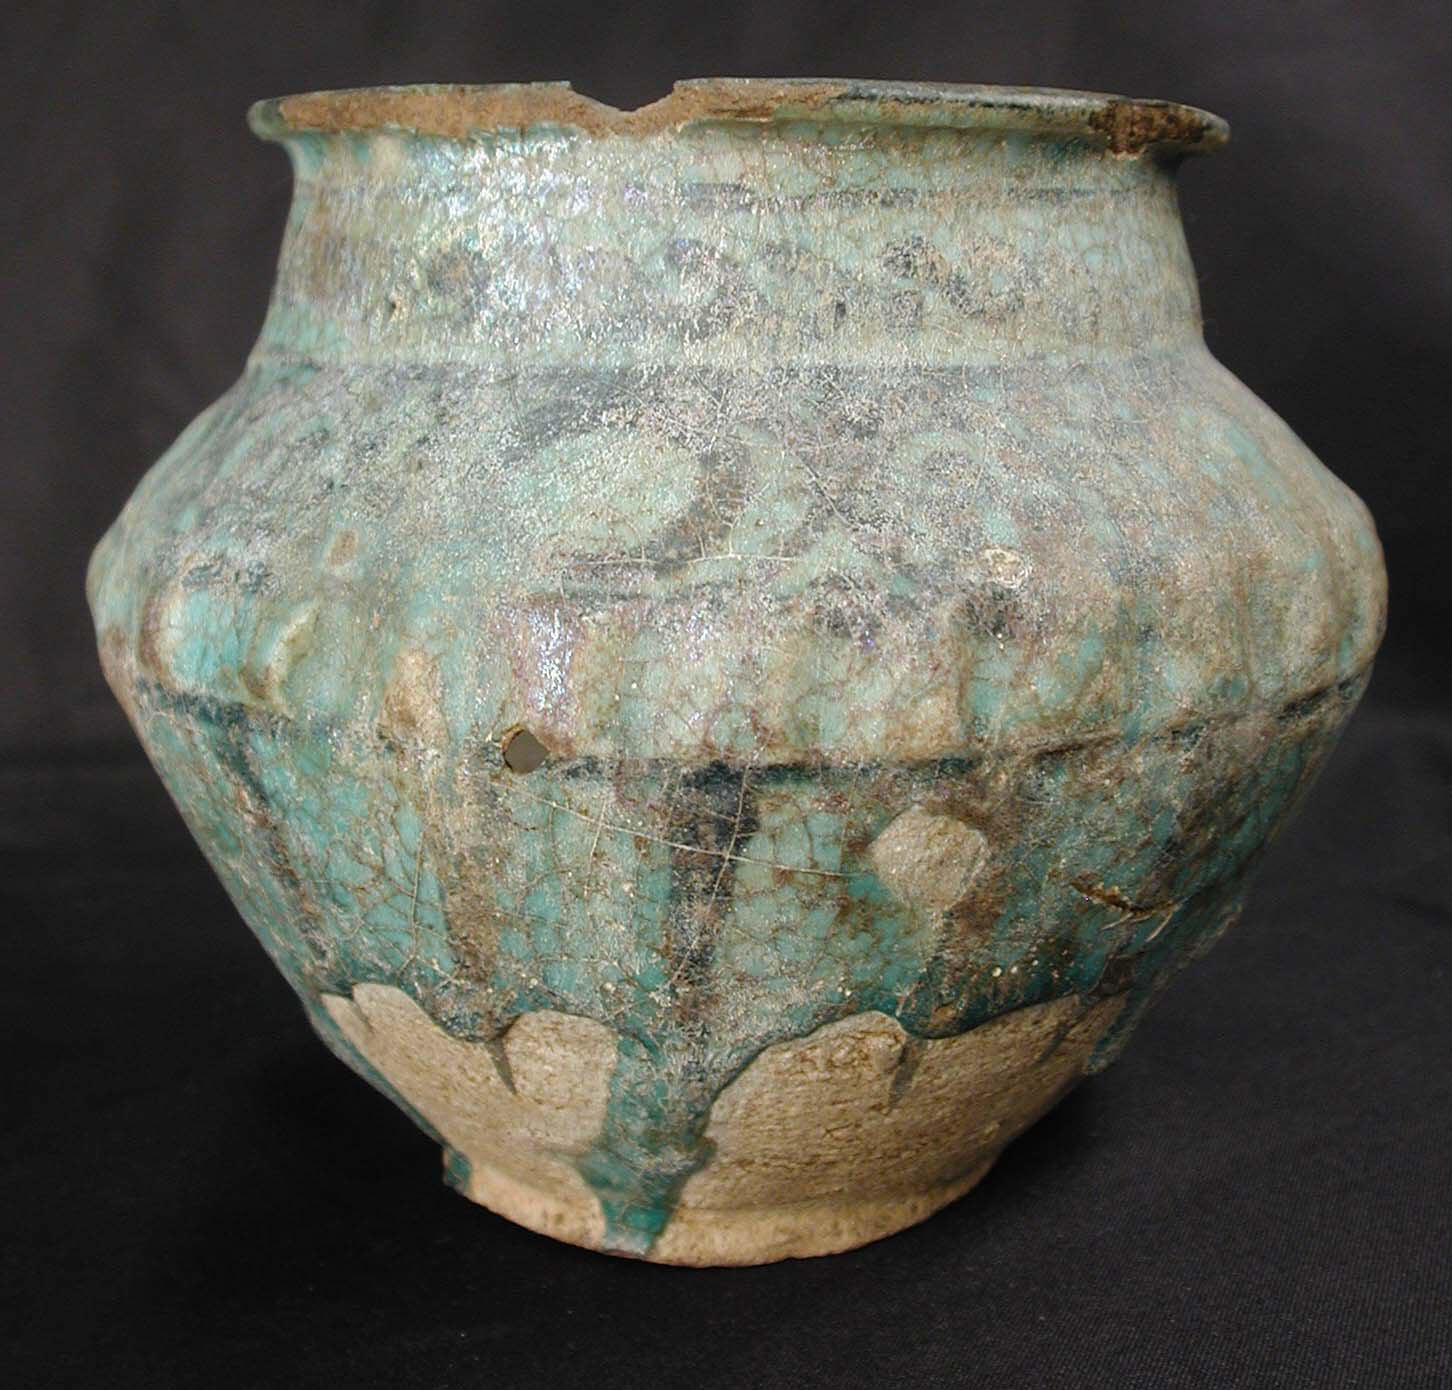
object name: jar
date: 1201-1300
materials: earthenware, glaze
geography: iran